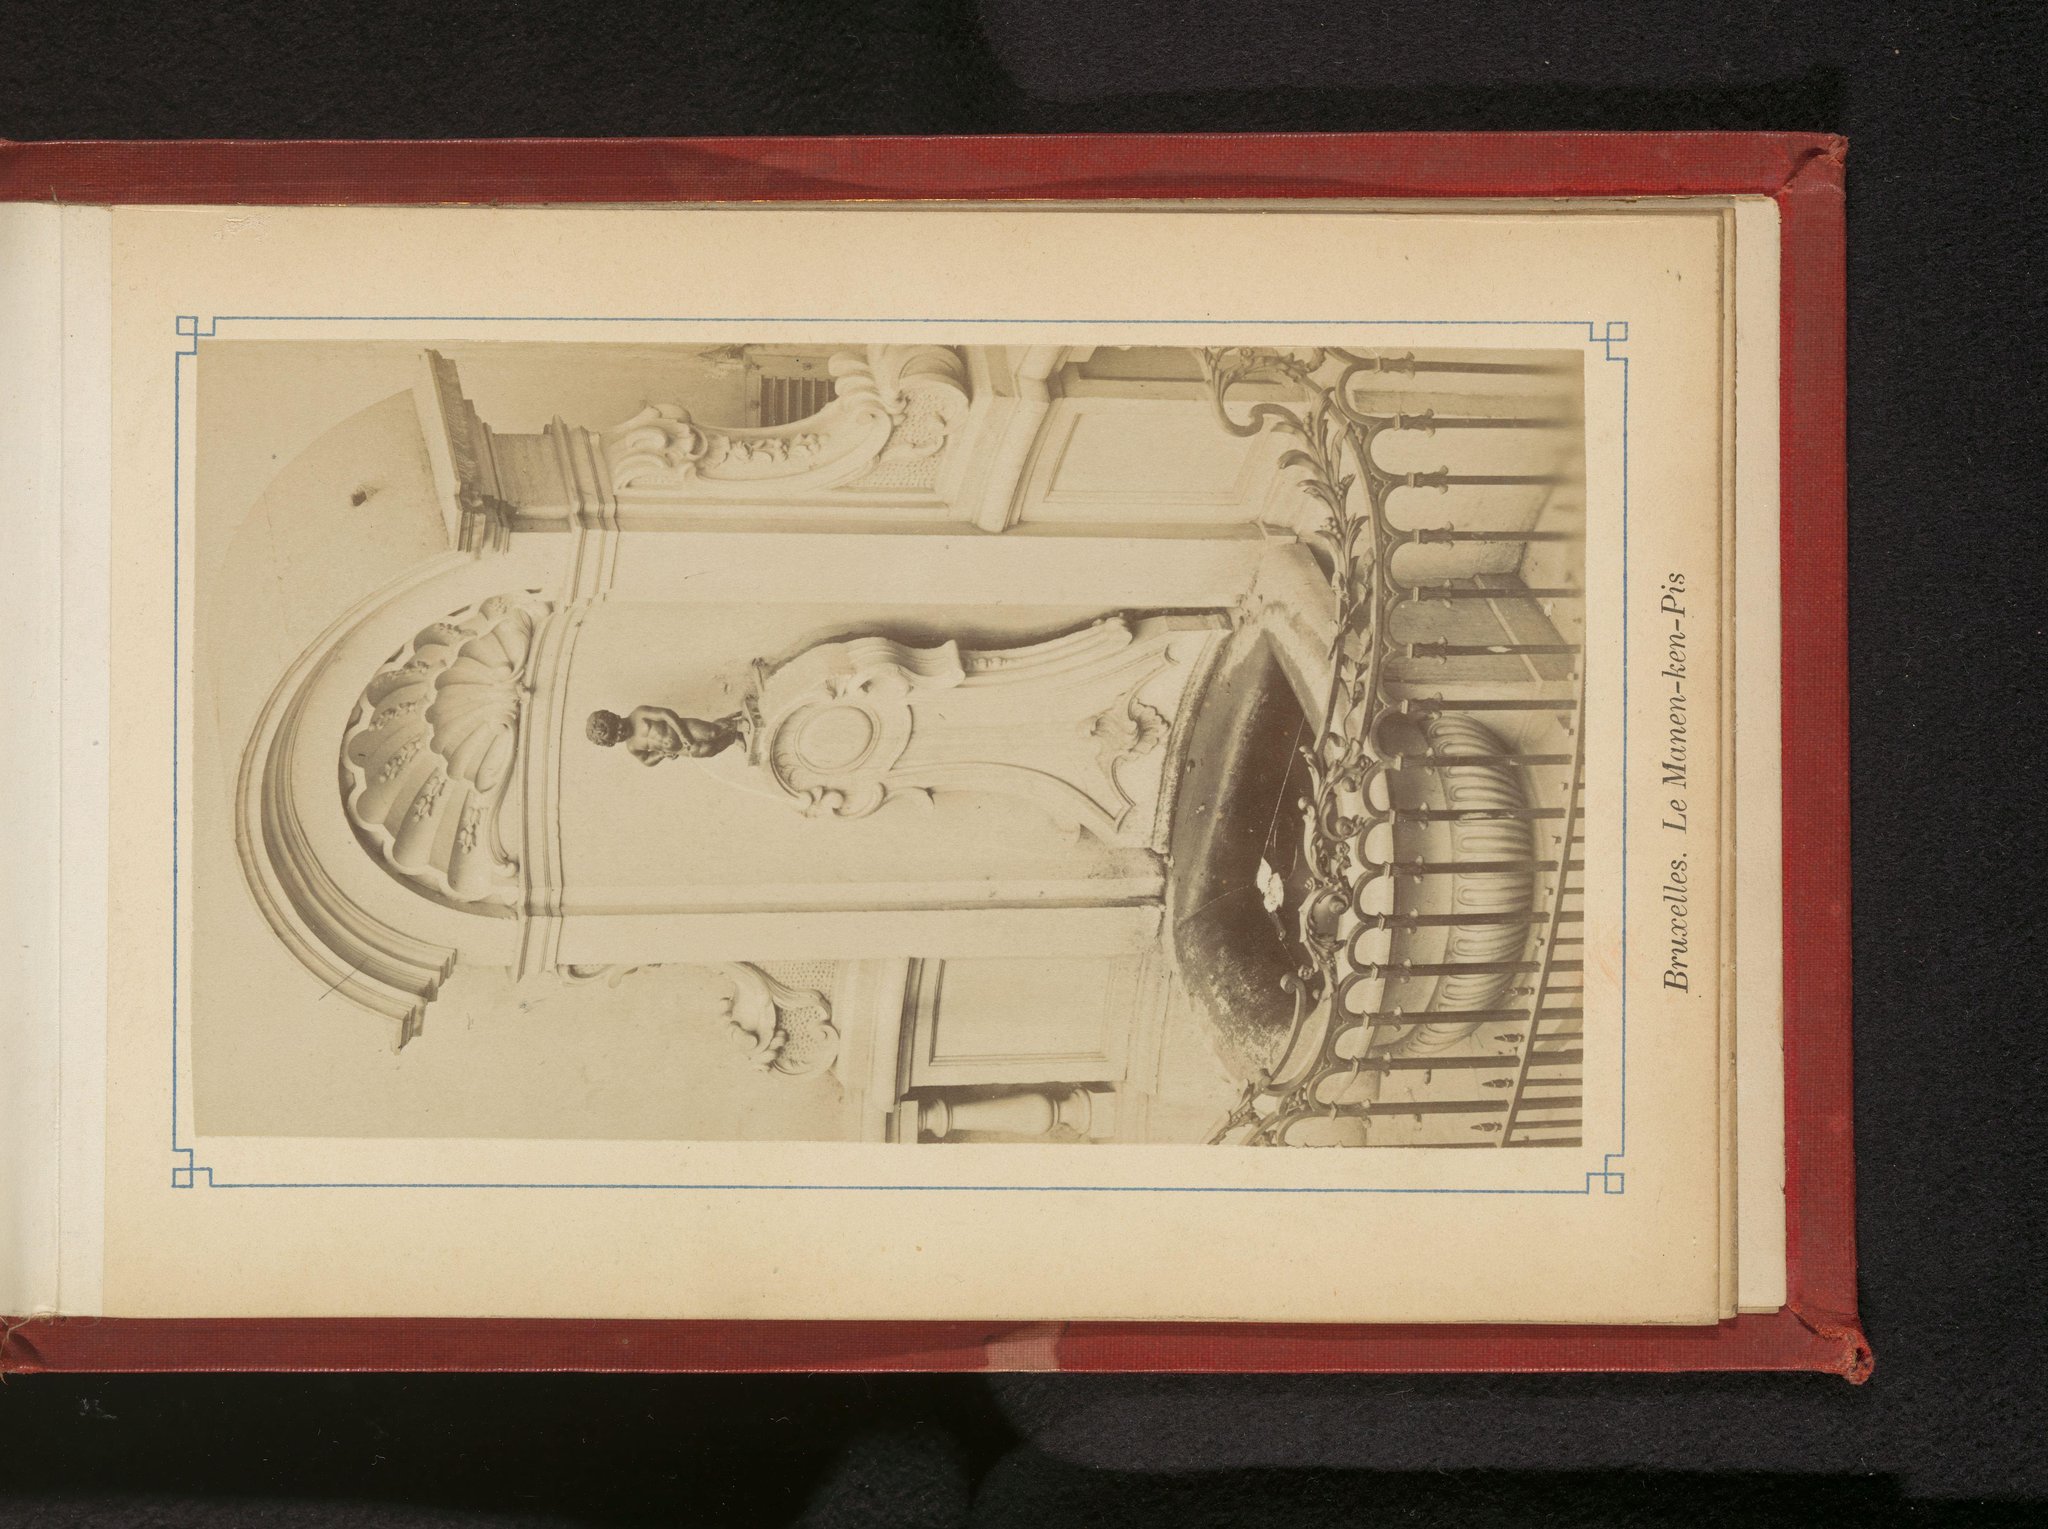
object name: page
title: Beeld van Manneken Pis in Brussel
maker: Anonymous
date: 1875-1880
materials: photographic support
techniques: albumen print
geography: brussels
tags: monument, statue